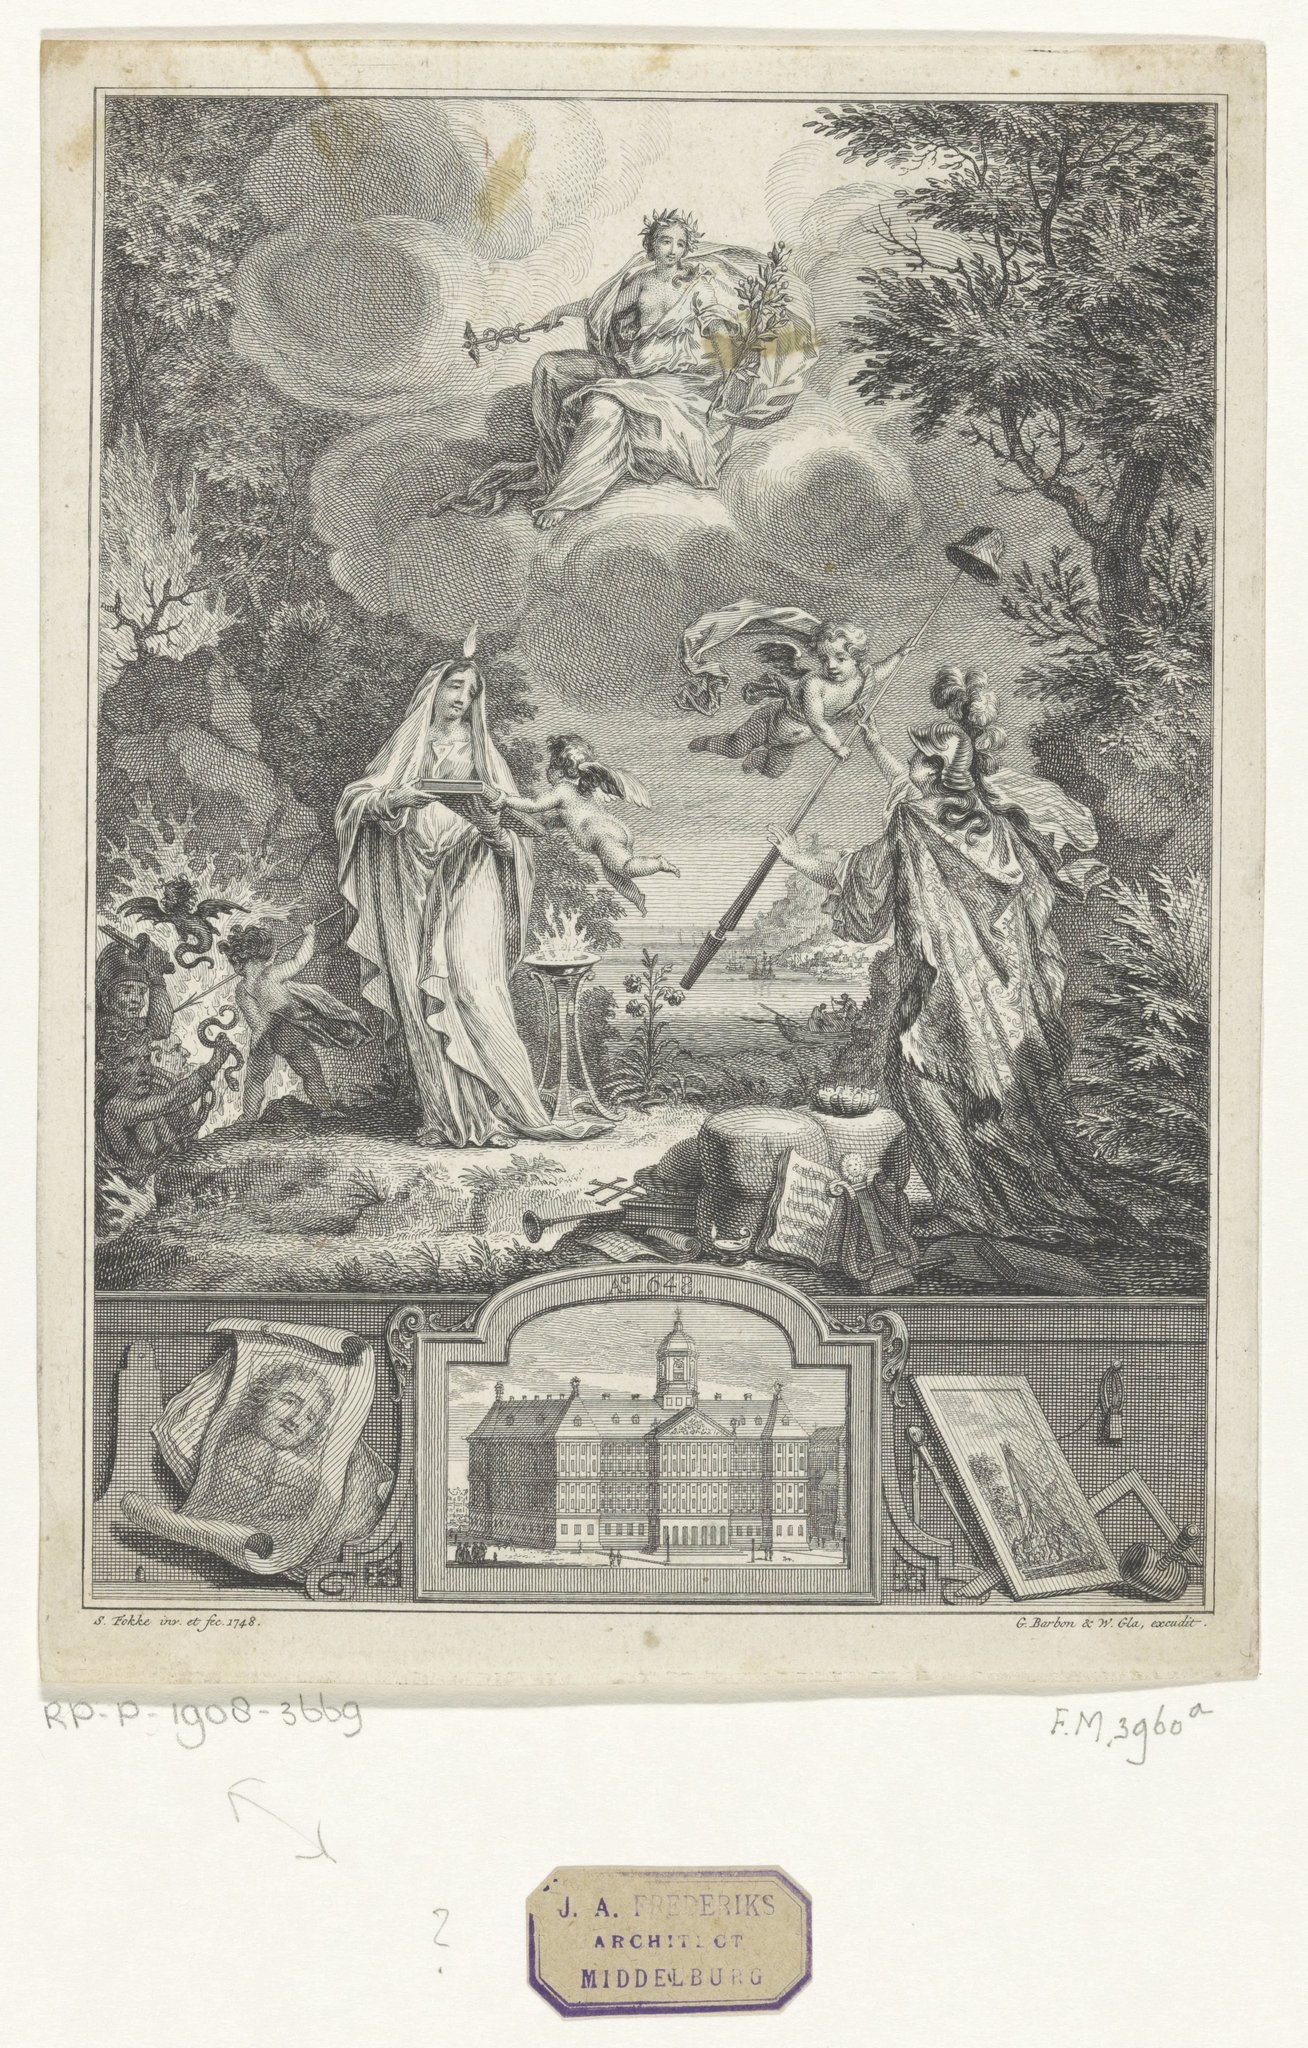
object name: book illustration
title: Allegorie op het 100-jarig jubileum van Nederlands Vrijheid, 1648-1748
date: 1748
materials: paper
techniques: engraving, etching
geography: amsterdam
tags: haarlem, print maker, draughtsman, jacob van campen, freedom, liberty; 'libertà' (ripa)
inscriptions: stamp: ‘J. A Frederik / architect / Middelburg’, collector's mark: Lugt 2228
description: De gelauwerde personificatie van de Vrede troont in de lucht met een olijftak en een caduceus. Onder haar ontvangt Minerva een lans met vrijheidshoed van een putto. Een tweede putto biedt de Waakzaamheid in het midden een boek aan. Geheel links jaagt een derde putto duivelse figuren met een speer een vlammenzee in. Aan de onderzijde het in 1648 voltooide Stadhuis op de Dam te Amsterdam met een portret van Jacob van Campen en een voorstelling van heiwerkzaamheden bij de bouw.